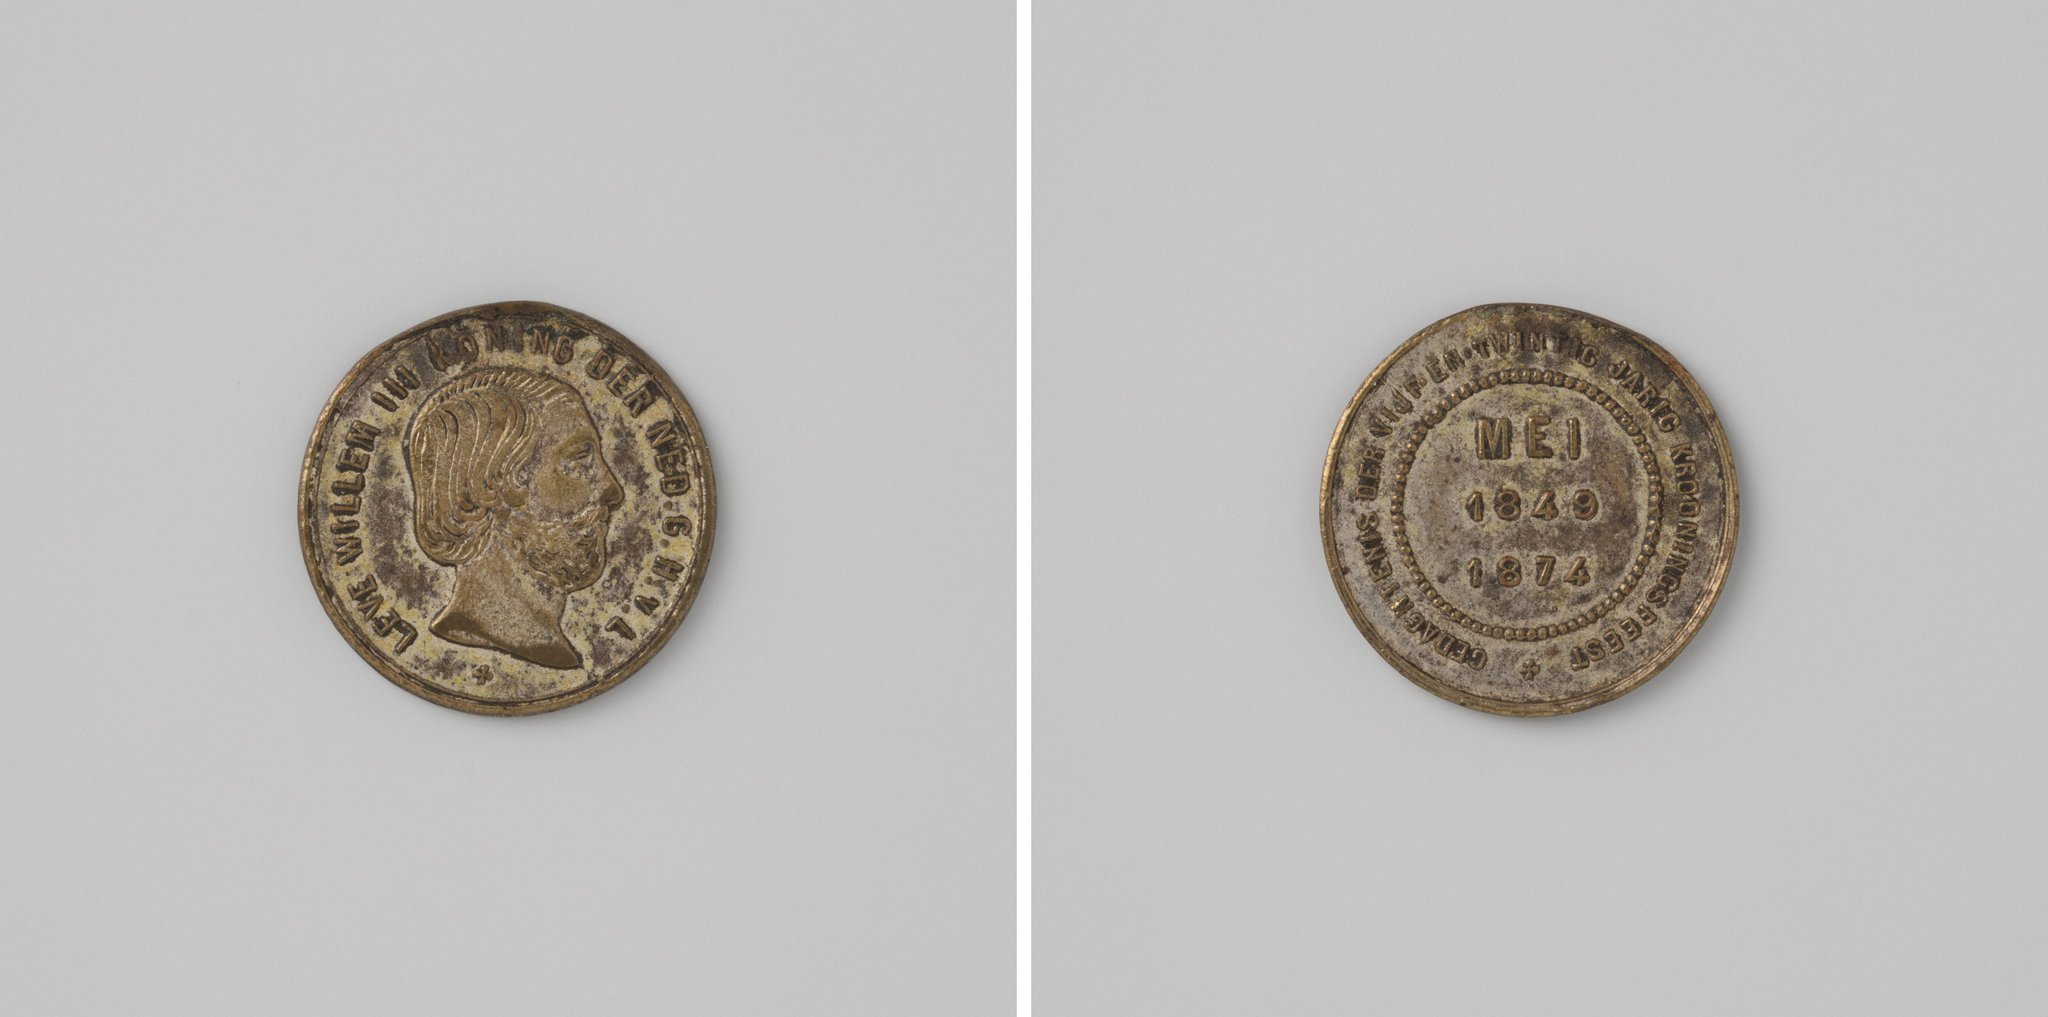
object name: history medal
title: Vijfentwintigjarig regeringsjubileum van Koning Willem III 1874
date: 1874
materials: brass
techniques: striking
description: Klein verzilverd messing penninkje met verwijderd draagoog, op de voorzijde het portret van Willem III naar rechts met omschrift, op de keerzijde drie regels tekst met omschrift.